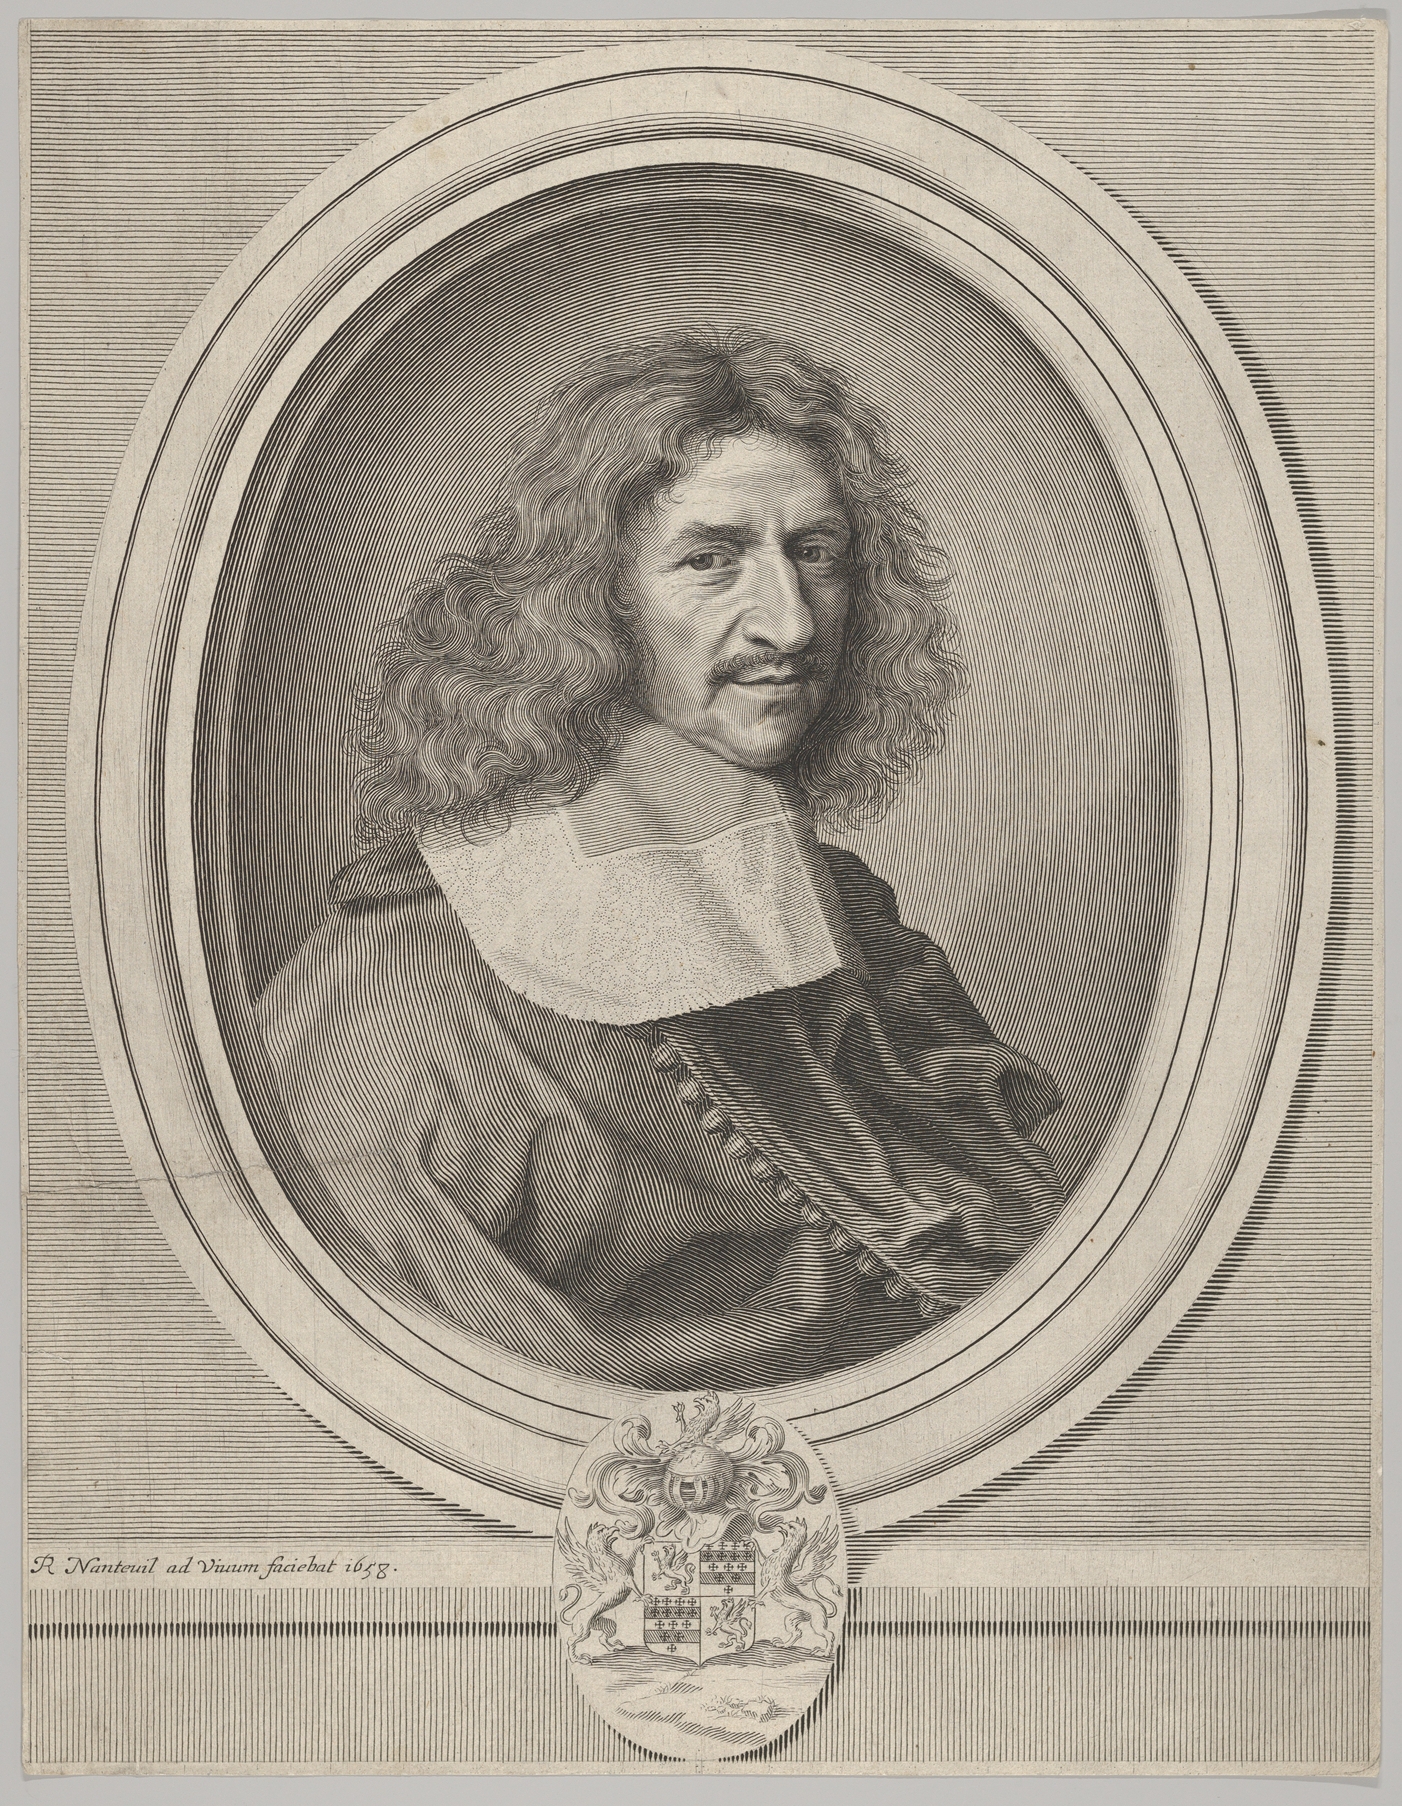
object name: print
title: Louis Hesselin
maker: robert nanteuil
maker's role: artist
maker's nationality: french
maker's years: 1623-1678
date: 1658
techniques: engraving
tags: men,portraits,coat of arms